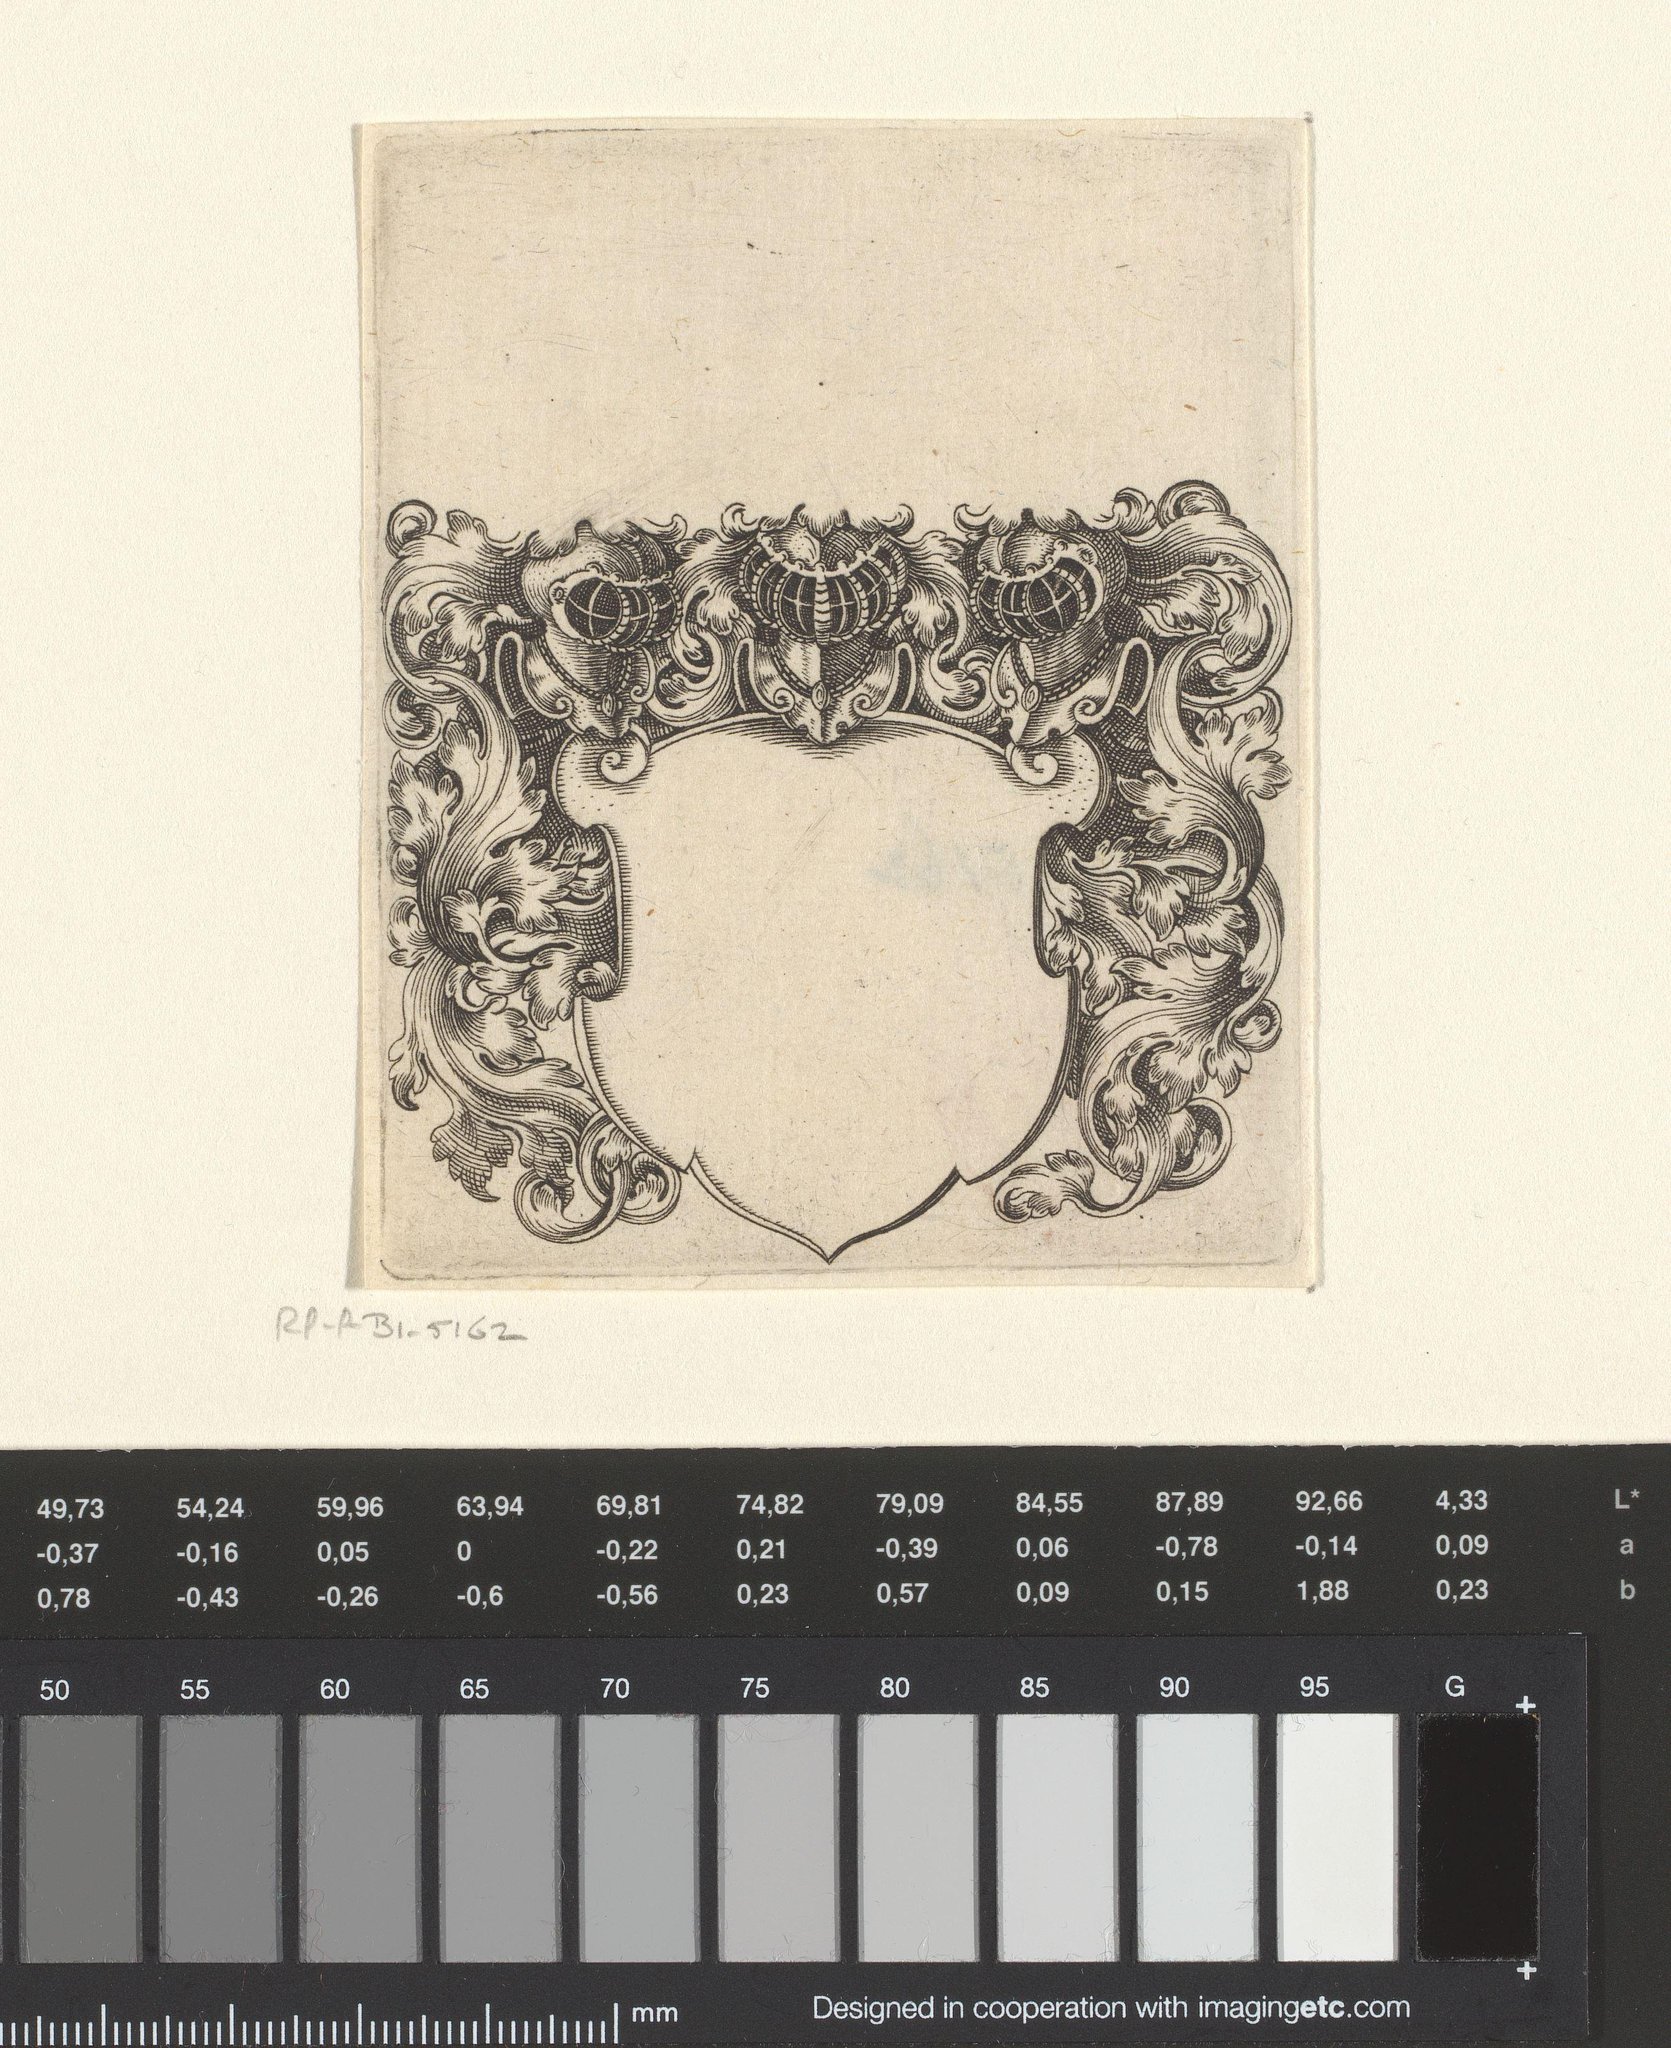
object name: book illustration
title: Emblemata Saecularia, 1596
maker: johann theodor de bry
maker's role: print maker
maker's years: 1561-1623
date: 1596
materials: paper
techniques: engraving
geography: frankfurt am main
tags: armorial bearing, heraldry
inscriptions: collector's mark: Lugt 240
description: Afkomstig uit: Emblemata Saecularia. Mira et iucunda varietate seculi huius mores ita experimentia (...). 1e druk. Frankfurt am Main: J.T. de Bry en J.I. de Bry, 1596.